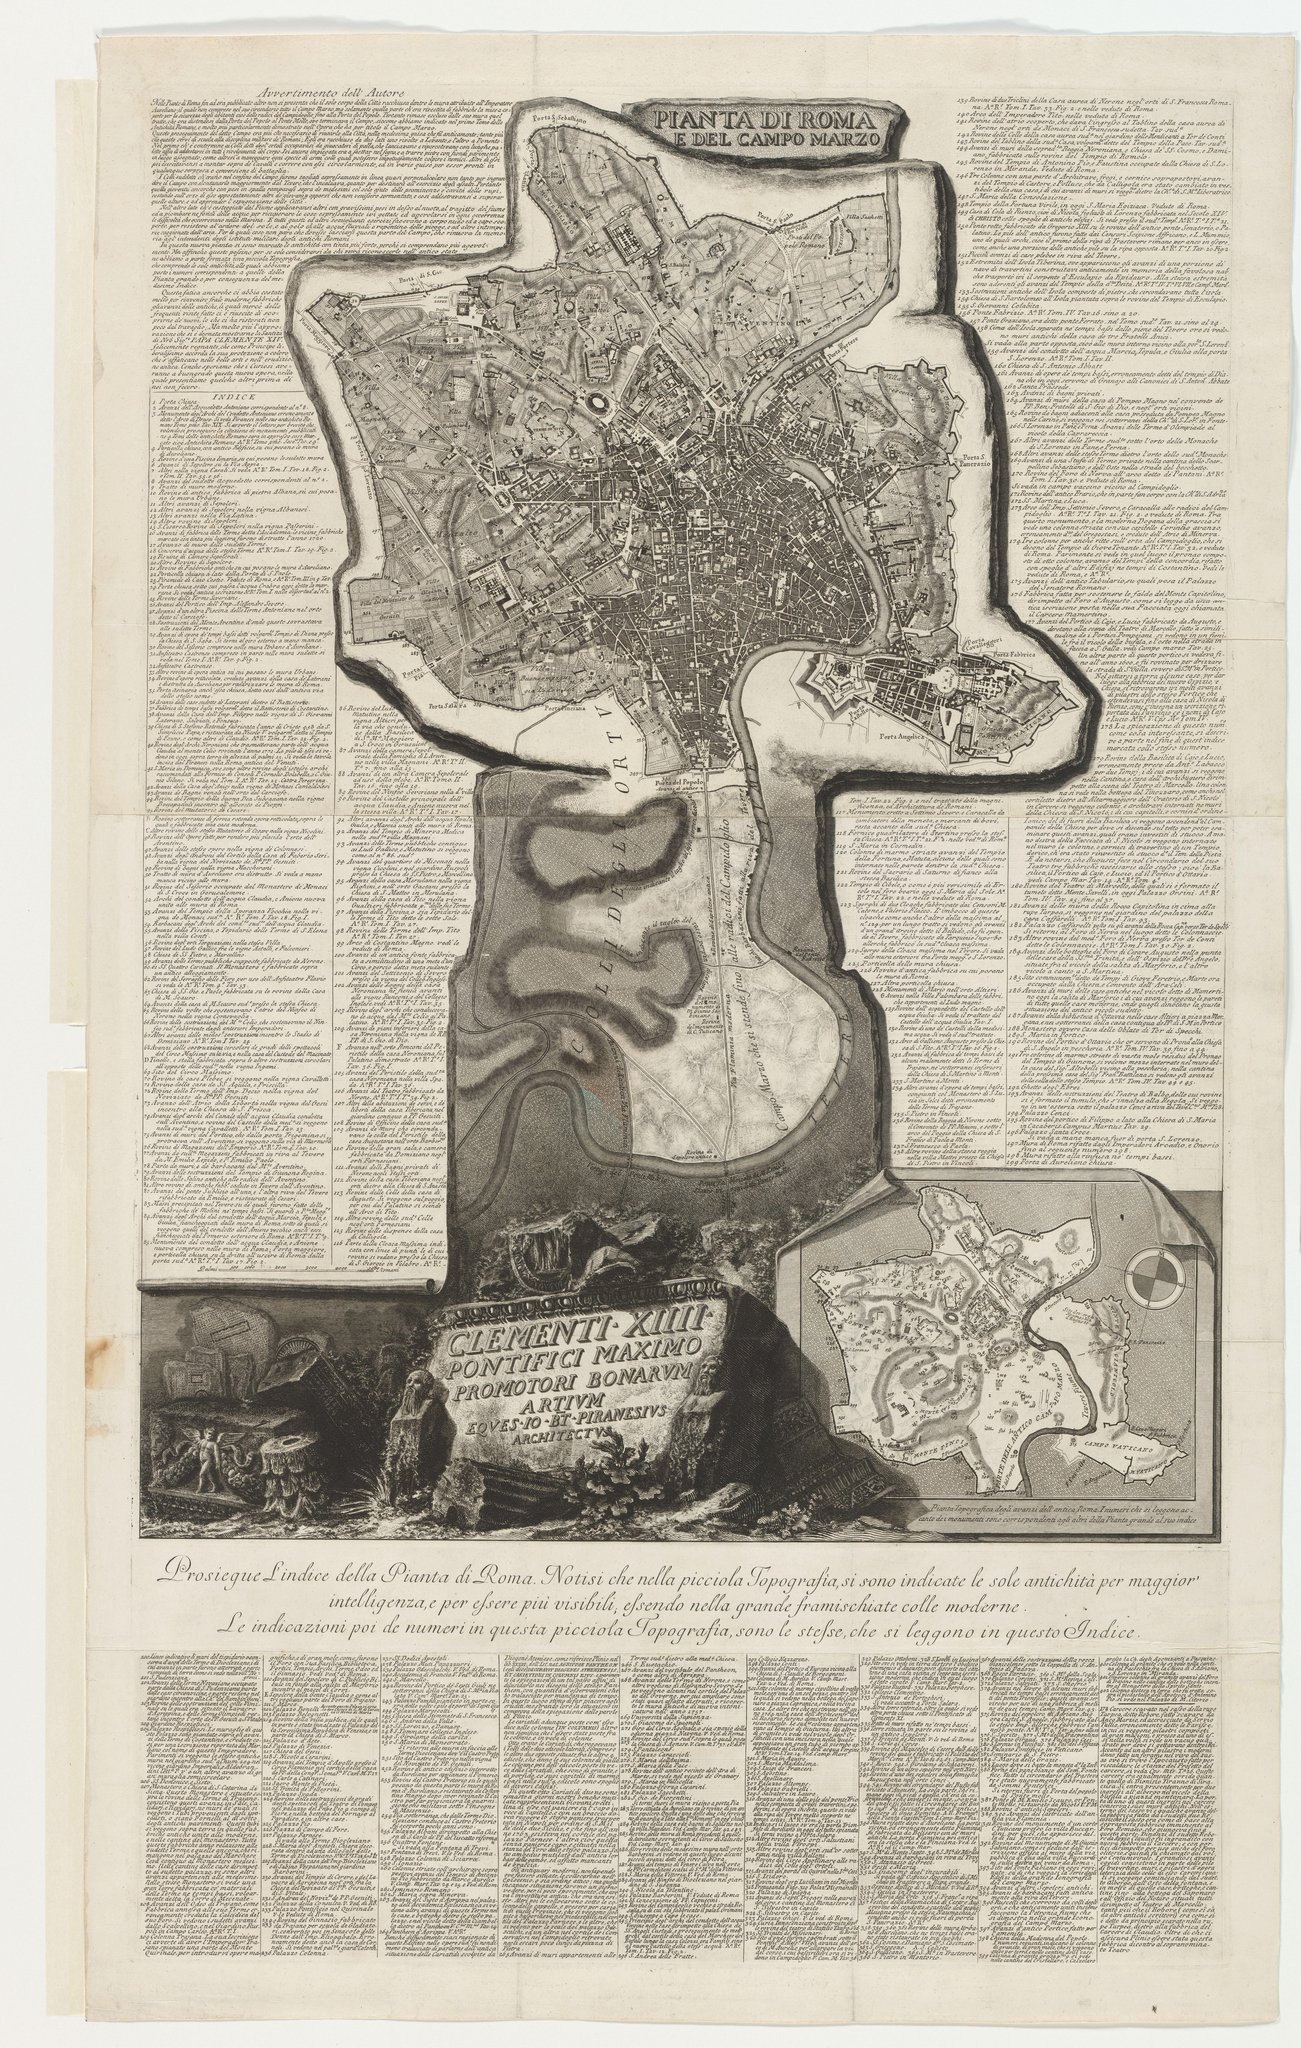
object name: print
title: Pianta di Roma e del Campo Marzo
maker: giovanni battista piranesi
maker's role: designer, draughtsman, print maker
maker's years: 1720-1778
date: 1774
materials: paper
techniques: etching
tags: maps of cities, rome